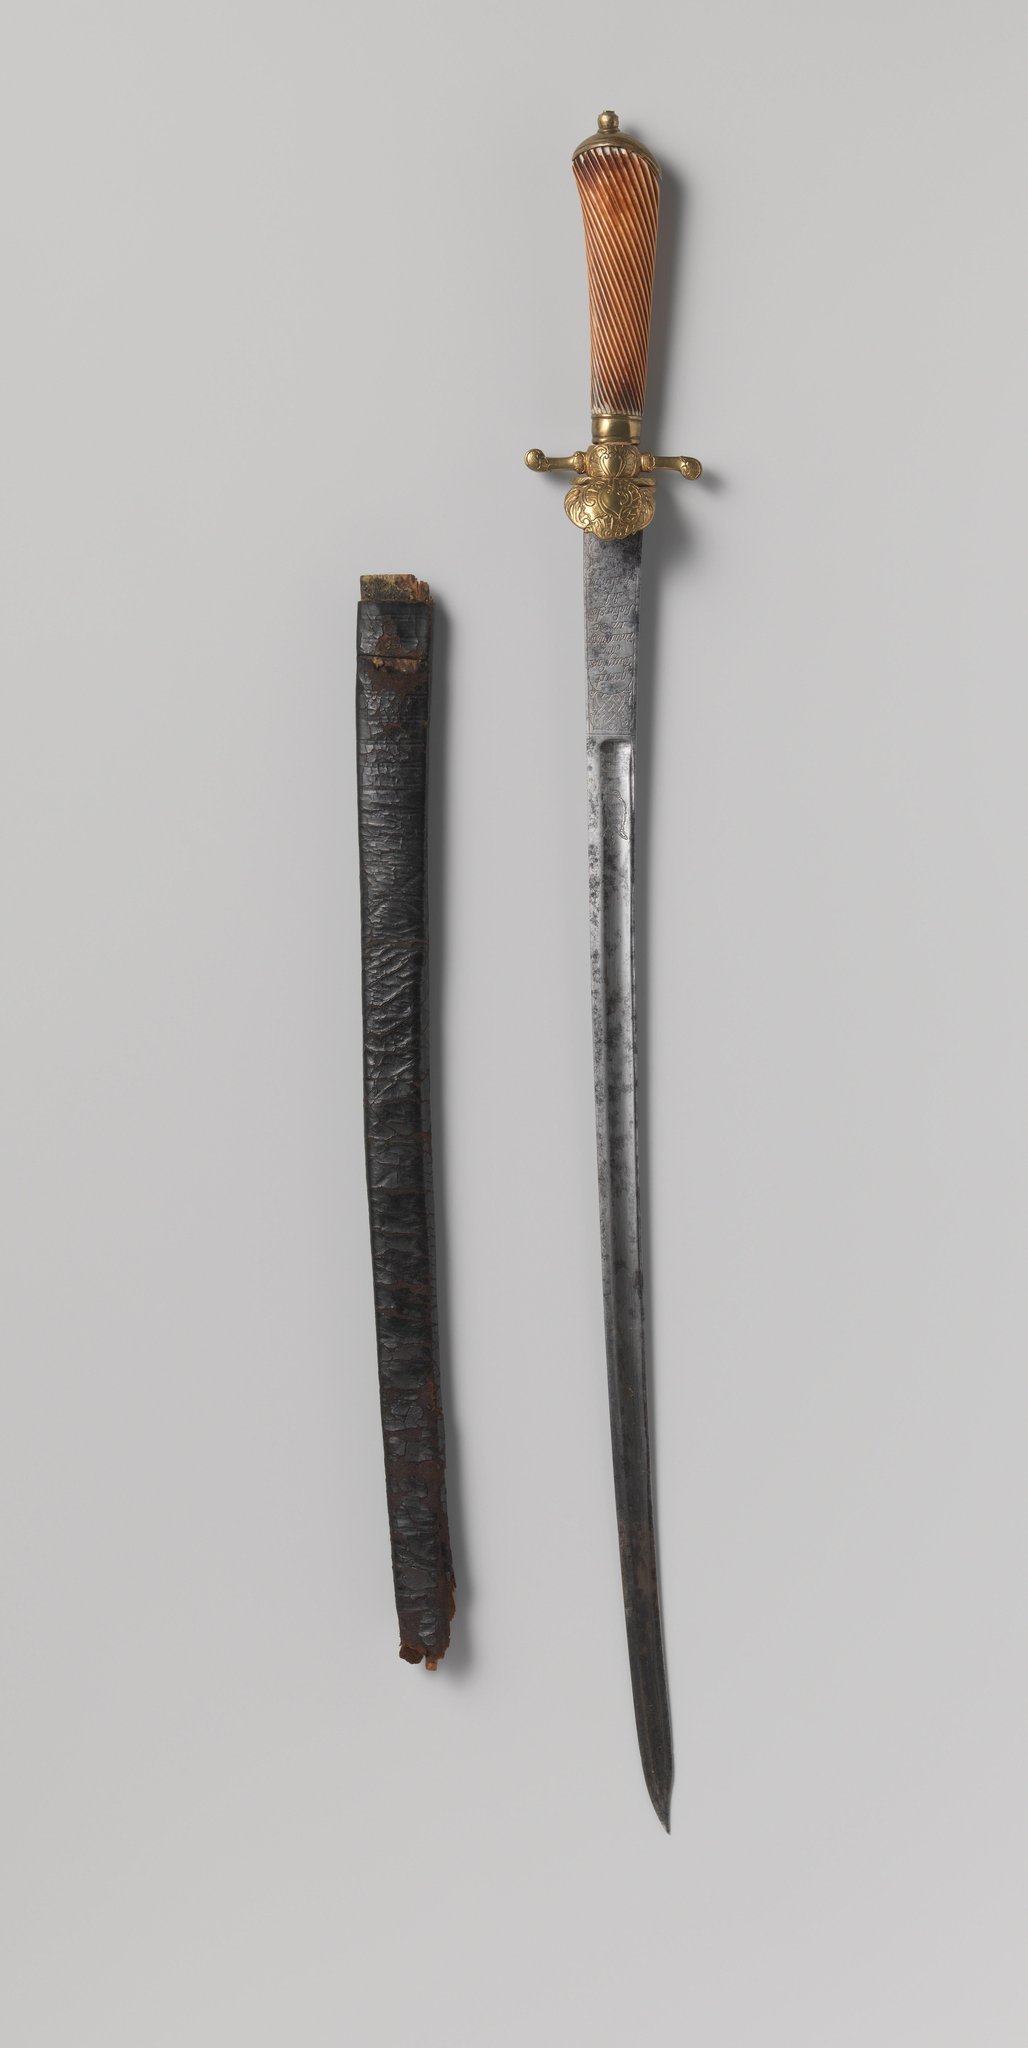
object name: sword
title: Kort recht gepunt zwaard met koperen pareerstang en hertshoornen greep met schede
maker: gerrit burghorst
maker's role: zwaardveger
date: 1700-1800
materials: copper, horn, iron, leather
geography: amsterdam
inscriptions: mark: ‘Gerrit Burghorst Mr Zwaardveger in de Kalverstraat tot Amsterdam’